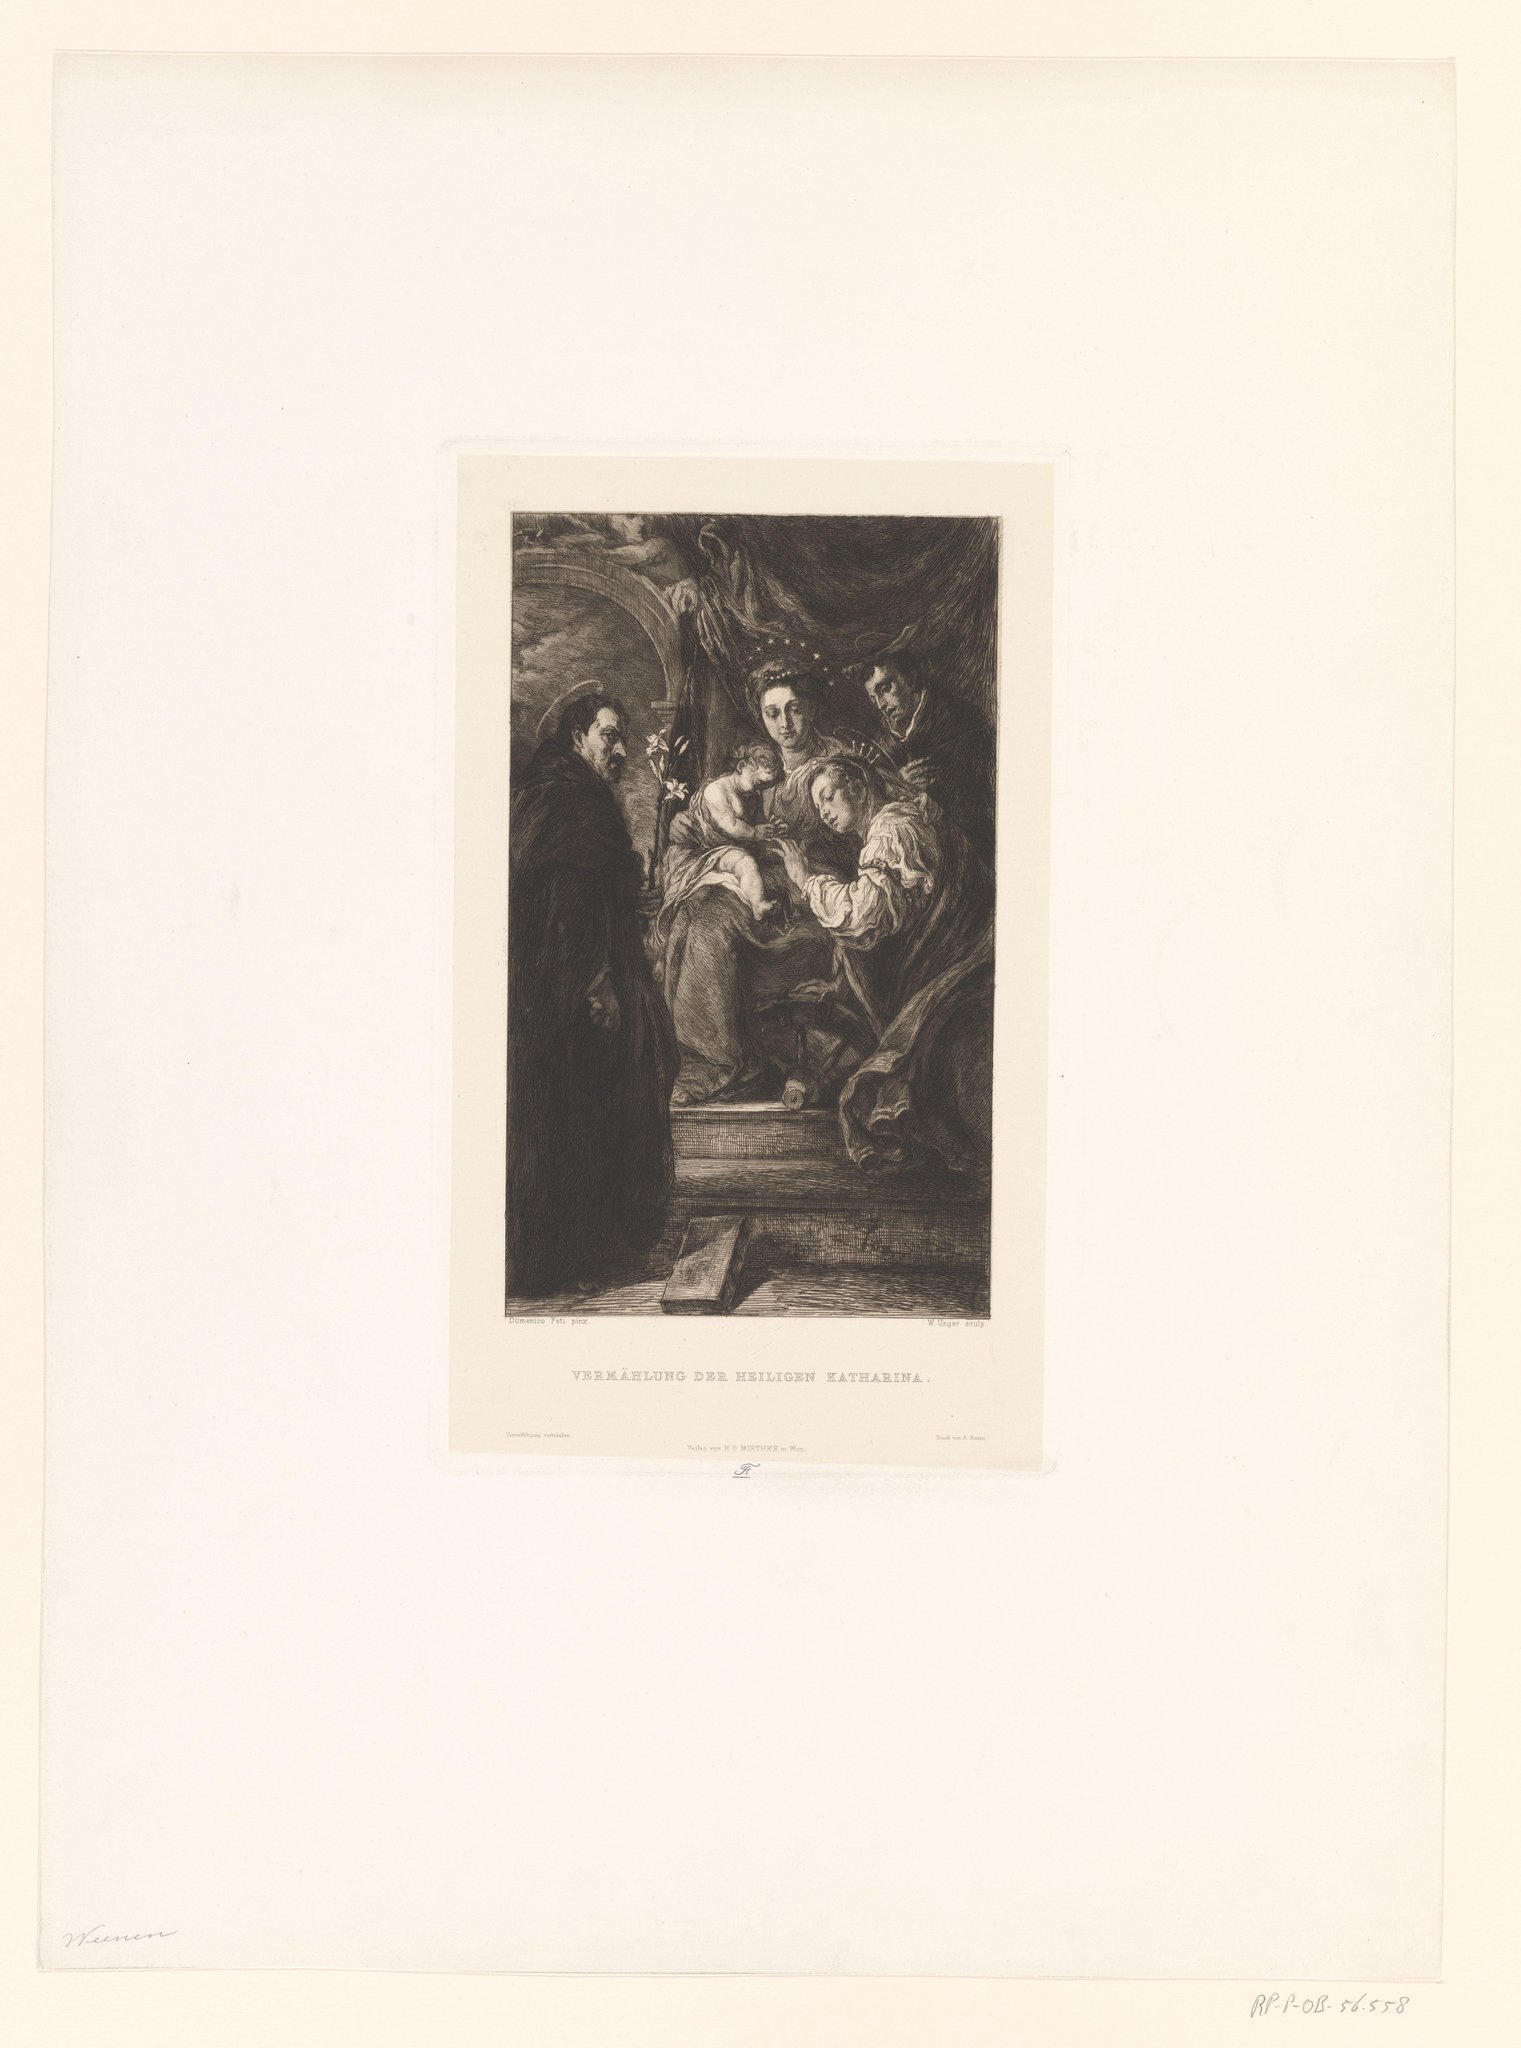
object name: print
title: Huwelijk van de heilige Catharina van Alexandrië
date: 1861-1889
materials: paper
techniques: etching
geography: vienna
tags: the mystic marriage of st. catherine of alexandria with the infant christ: the christ-child puts a ring on her finger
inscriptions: collector's mark: Lugt 2228